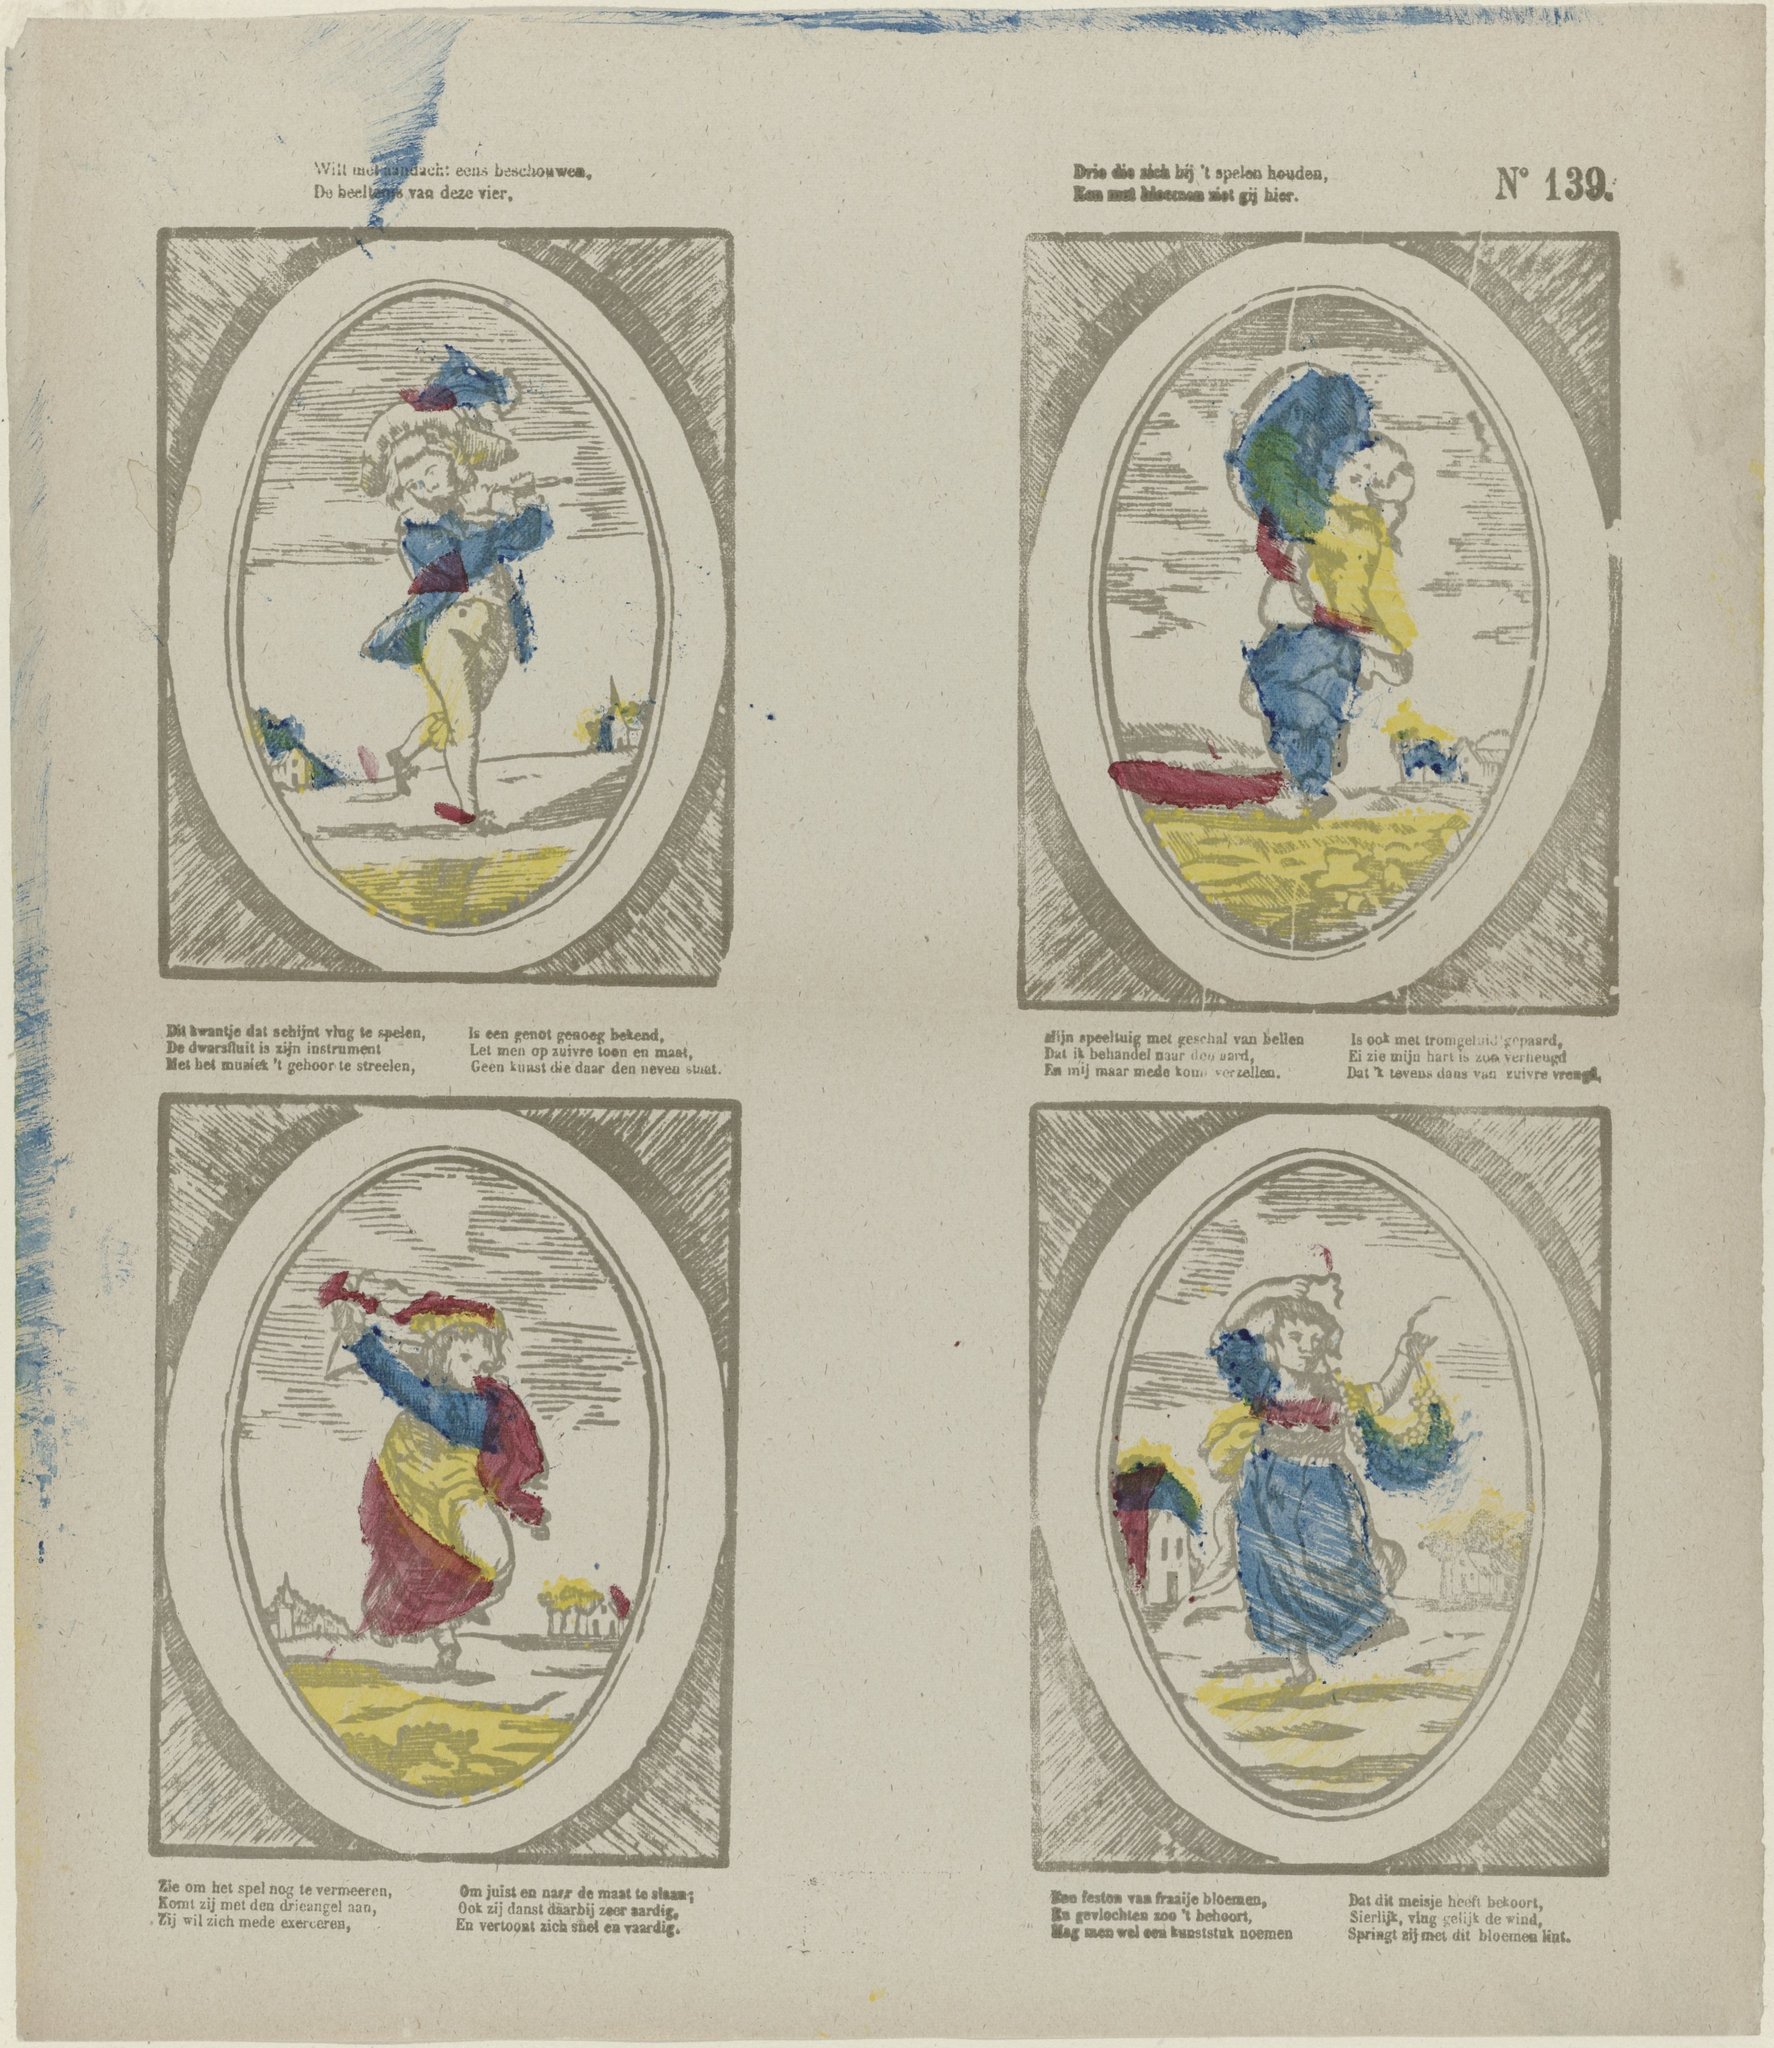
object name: print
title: Wilt met aandacht eens beschouwen, / De beeltenis van deze vier, / Drie die zich bij 't spelen houden, / Een met bloemen ziet gij hier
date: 1827-1894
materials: paper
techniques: printing, colour, letterpress printing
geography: schaarbeek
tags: making music; musician with instrument, dancing, child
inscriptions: collector's mark: Lugt 2760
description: Blad met 4 voorstellingen van dansende en musicerende kinderen, gevat in ovale lijsten. Onder elke afbeelding een zesregelig vers in twee kolommen. Genummerd rechtsboven: No 139.